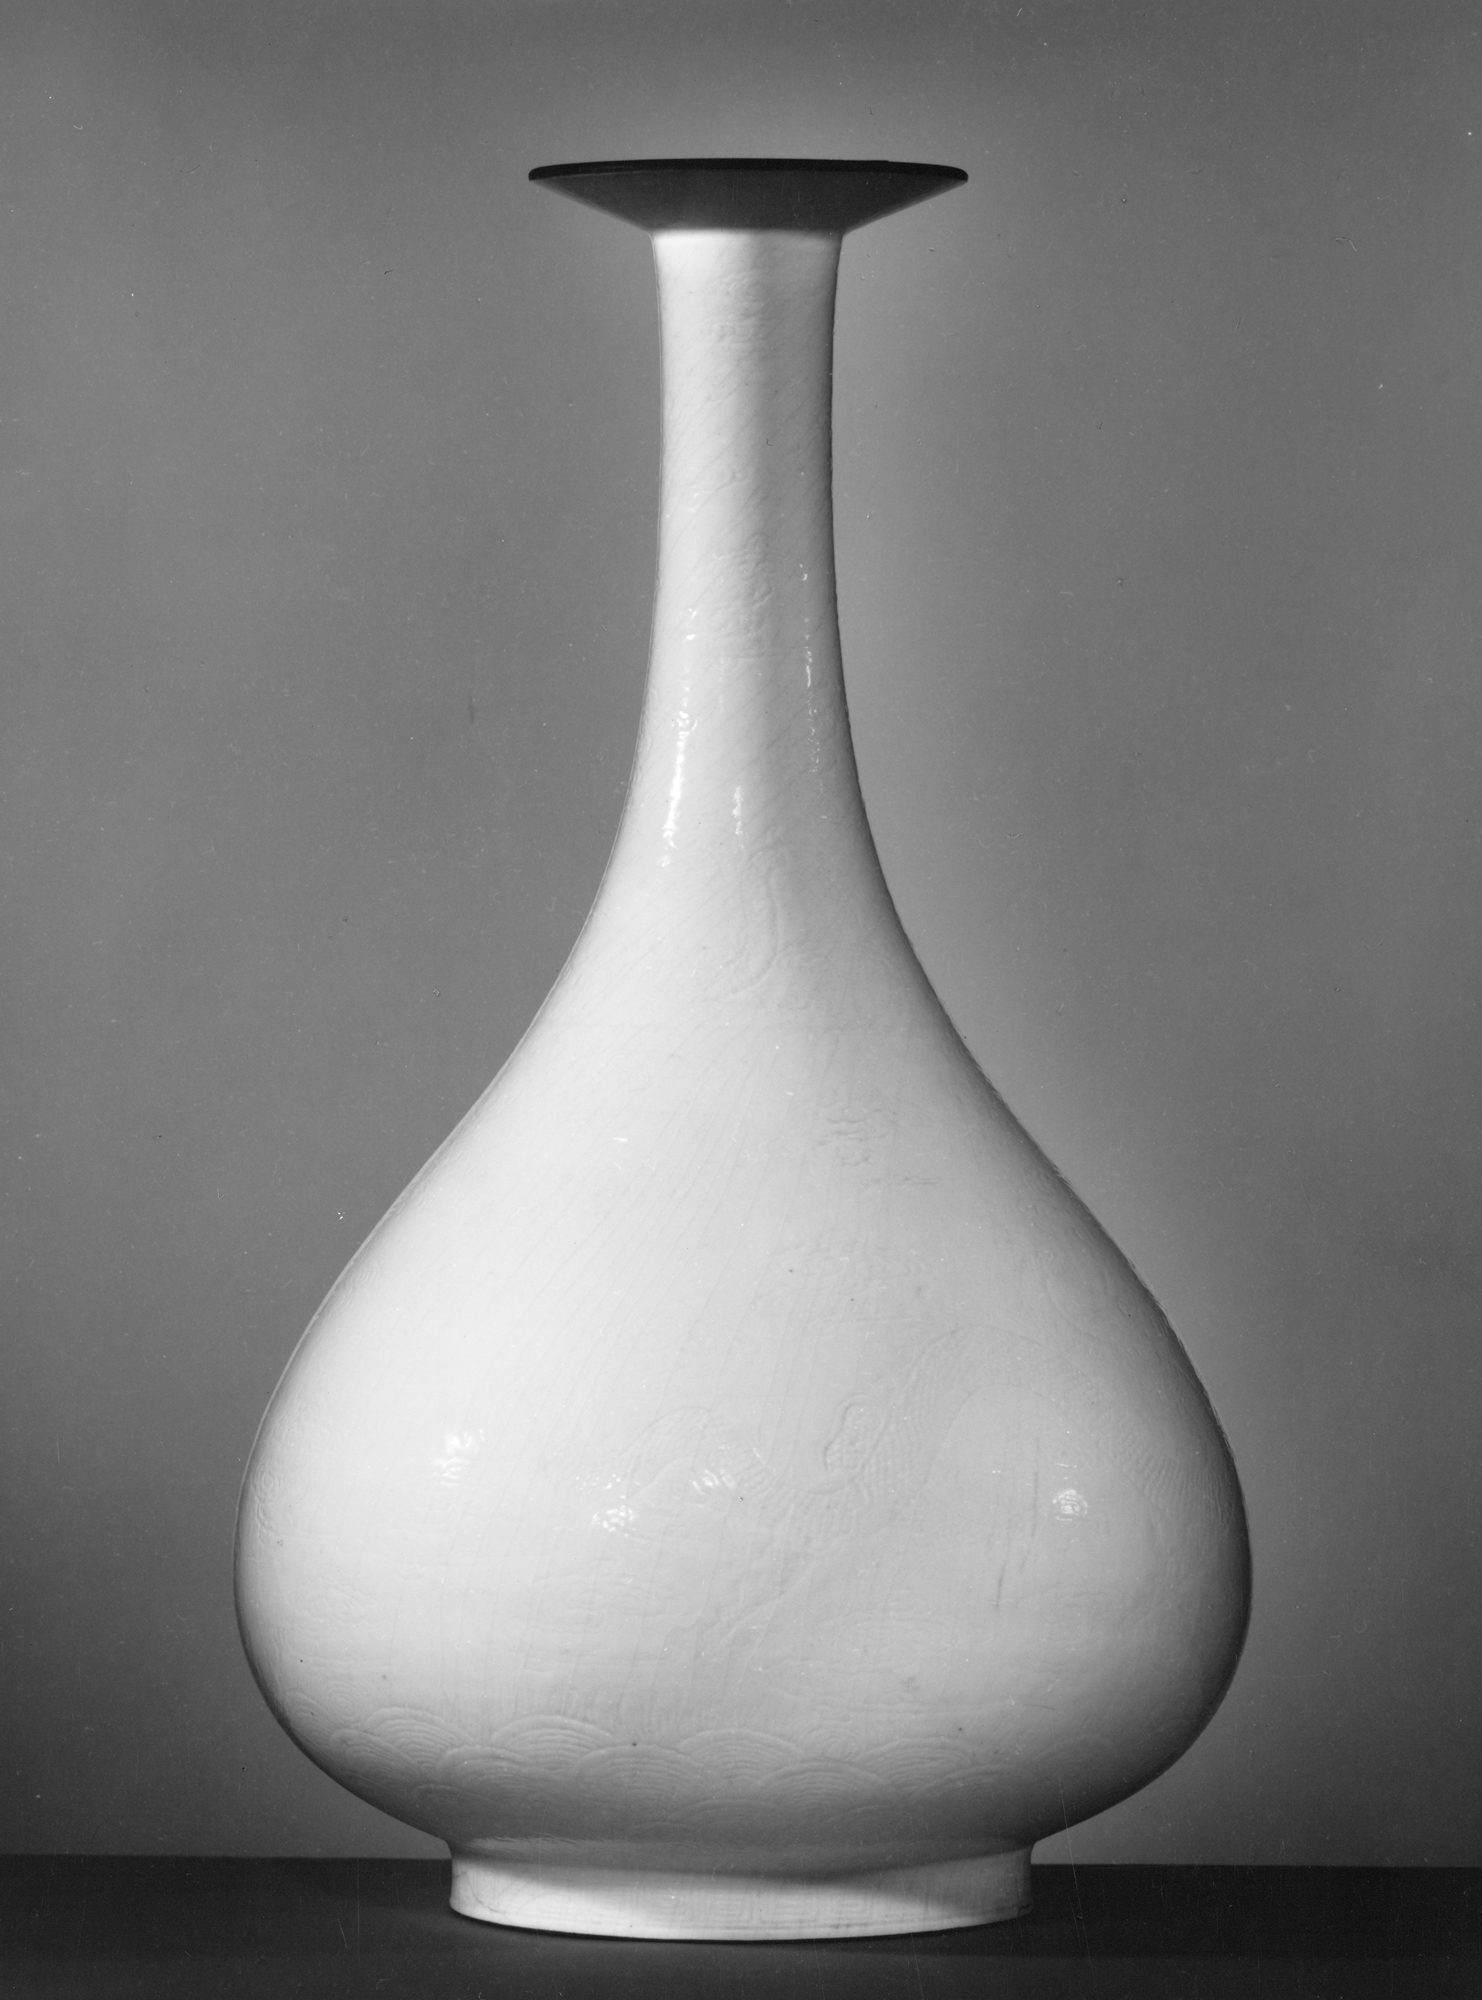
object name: bottle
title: Bottle with Dragons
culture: chinese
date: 1701-1750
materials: glaze, paste, porcelain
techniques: incising